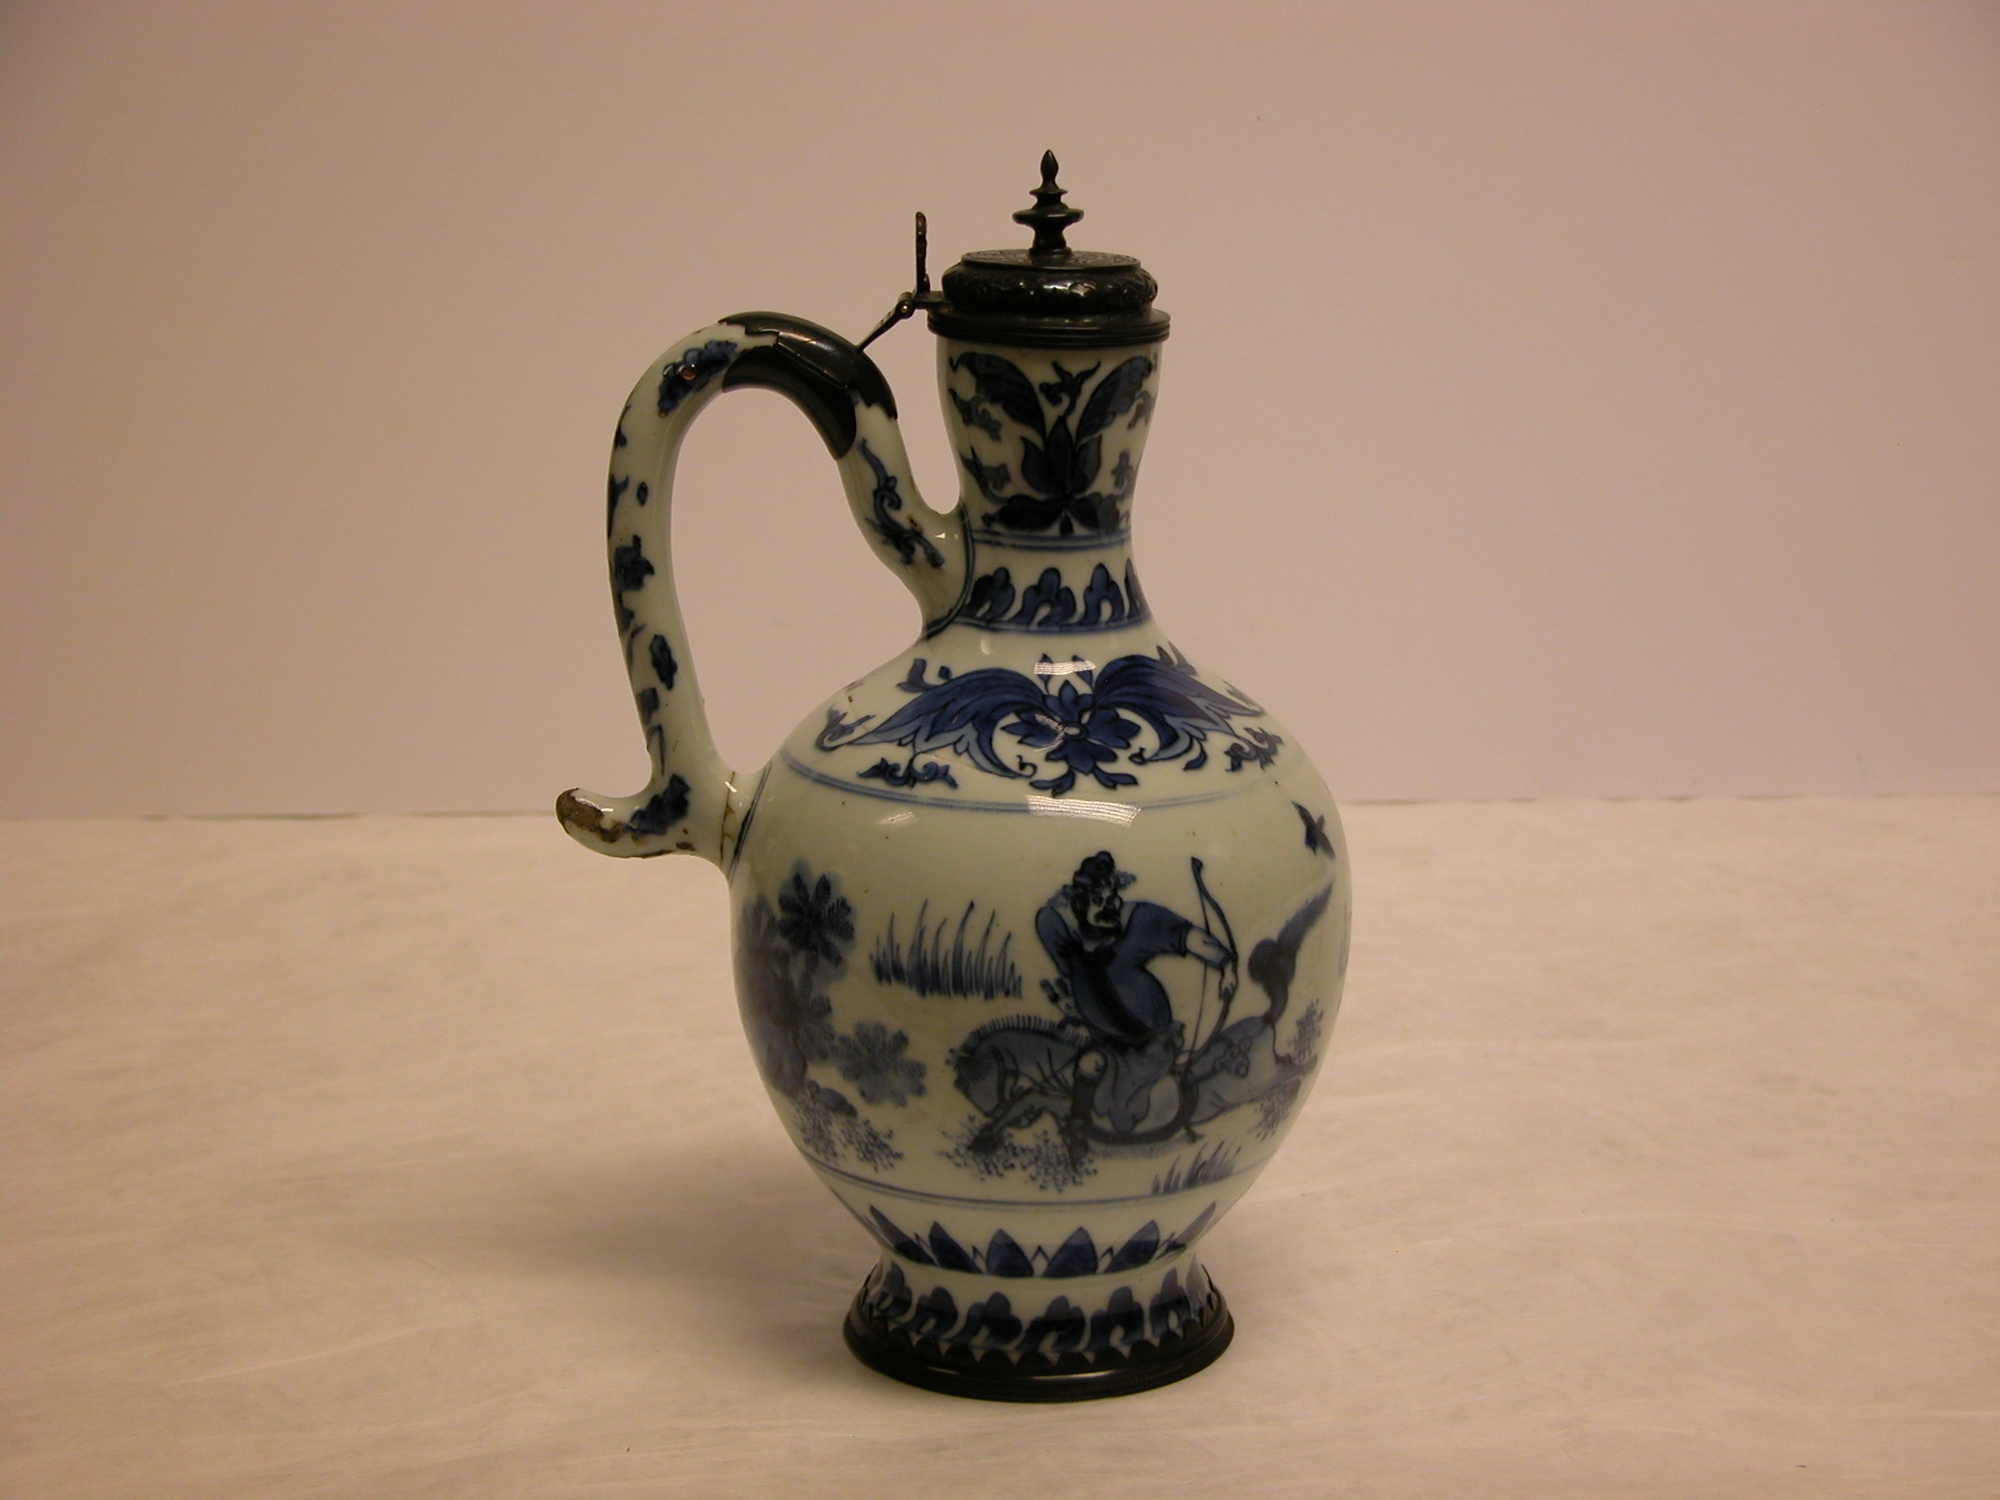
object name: ewer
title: Ewer with Equestrian Figure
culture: chinese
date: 1567-1633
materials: cobalt, glaze, porcelain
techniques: painting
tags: bow and arrow,horses